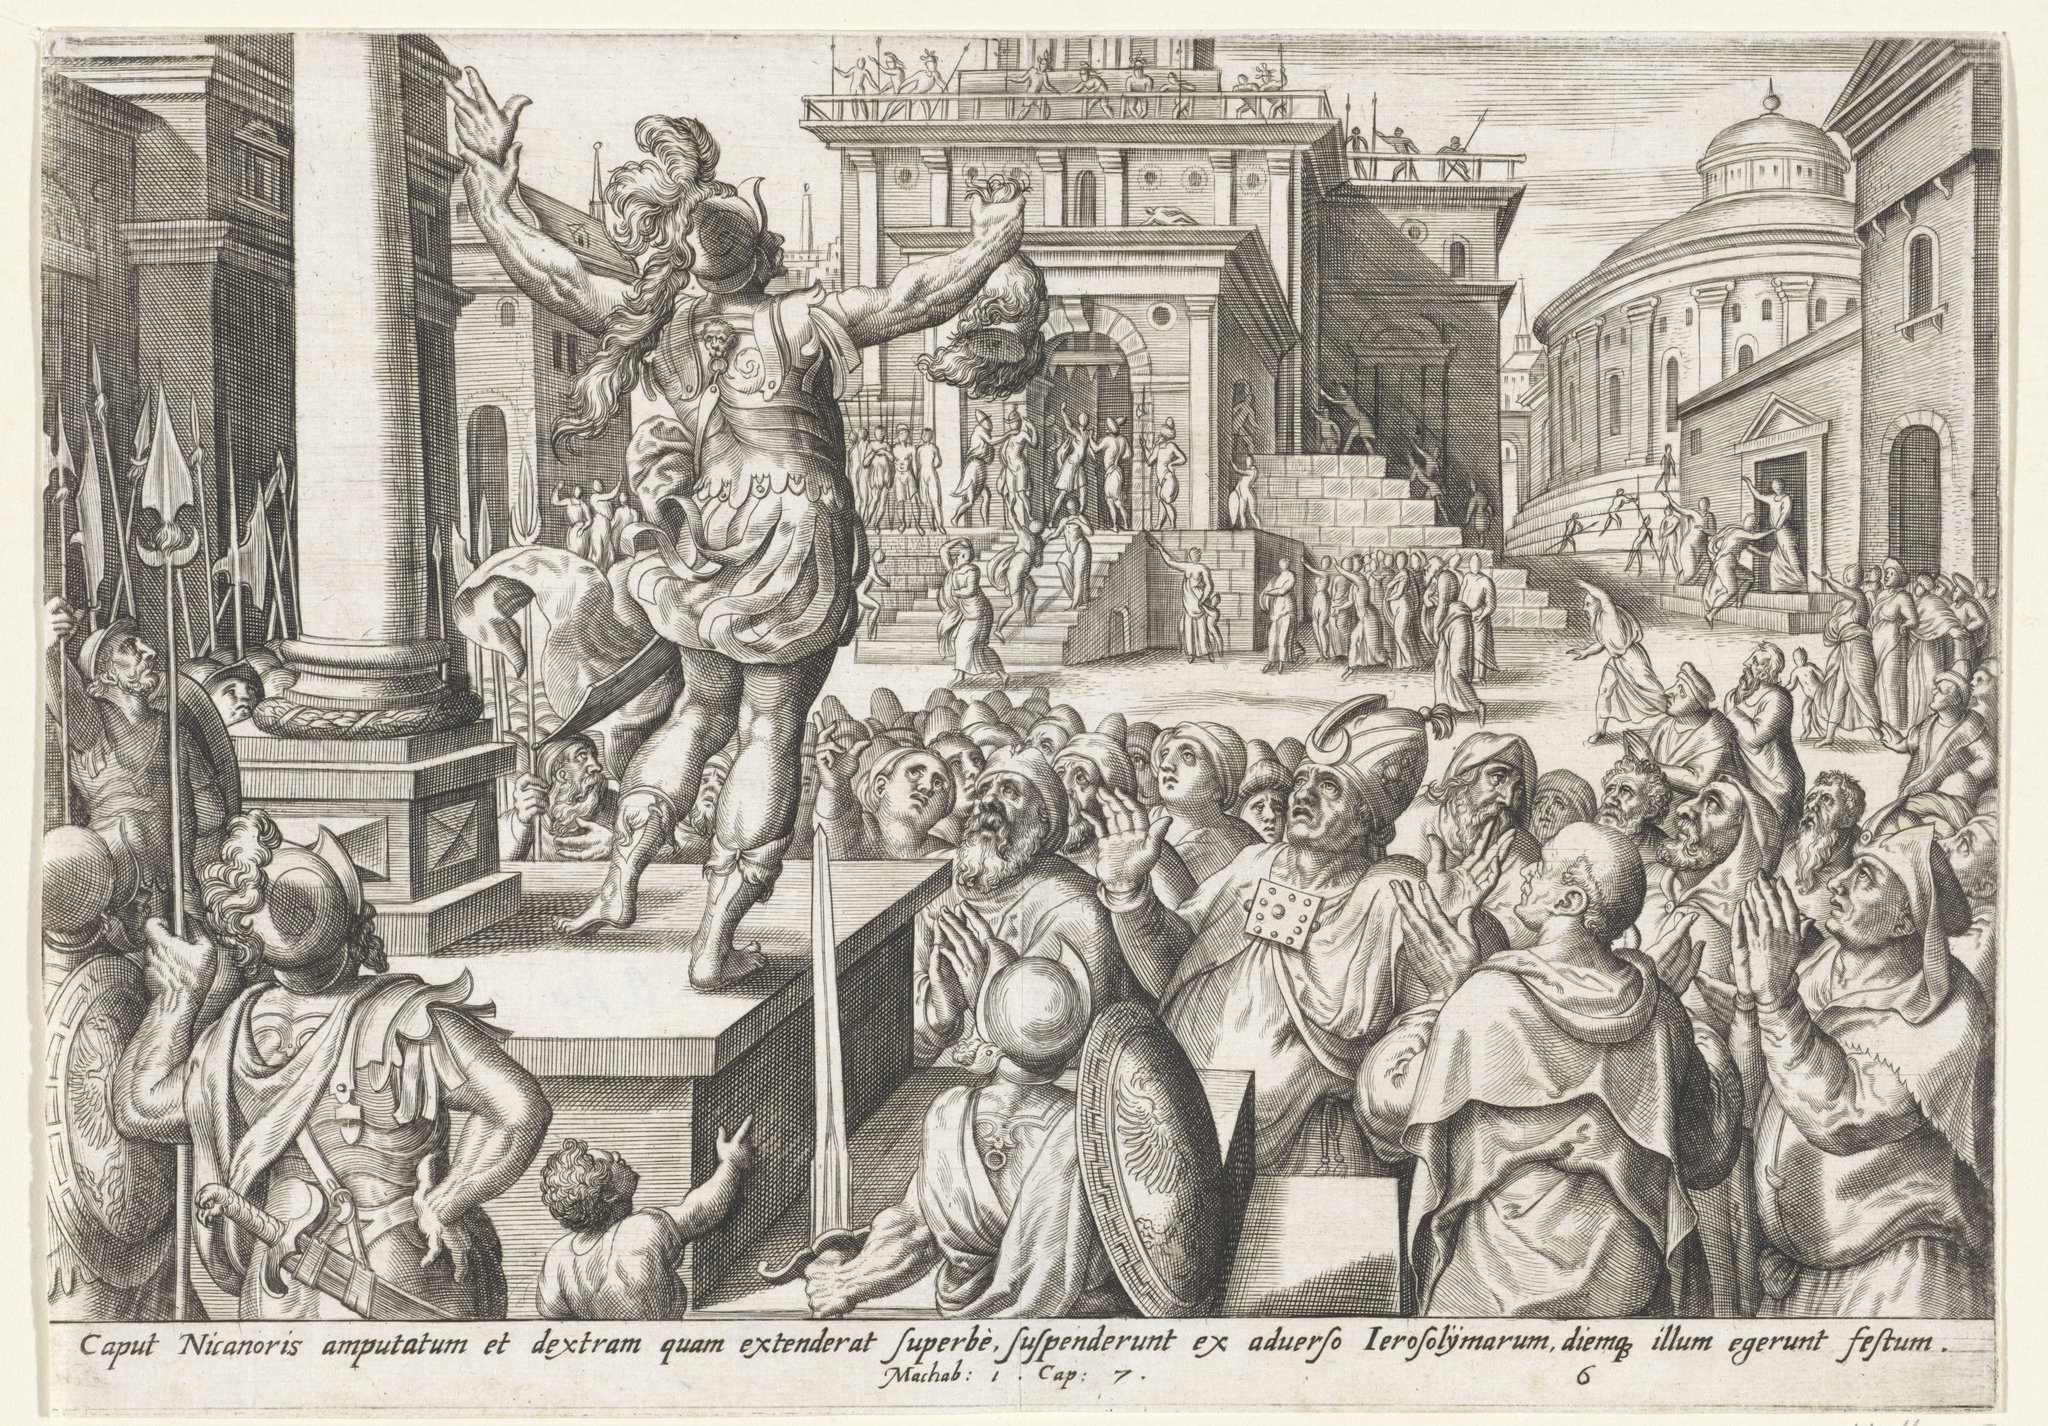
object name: print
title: Geschiedenis van de Makkabeeën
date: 1579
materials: paper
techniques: engraving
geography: antwerp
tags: nicanor's head and hand hung near jerusalem (+ variant)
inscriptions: collector's mark: Lugt 2228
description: Het afgehakte hoofd en de hand van Nikanor worden in Jeruzalem aan het volk getoond. Nikanor wilde Israël uitroeien, maar de Israëlieten overwonnen hem en zijn leger. Onder de voorstelling een verwijzing in het Latijn naar de Bijbeltekst in 1 Makk. 7.